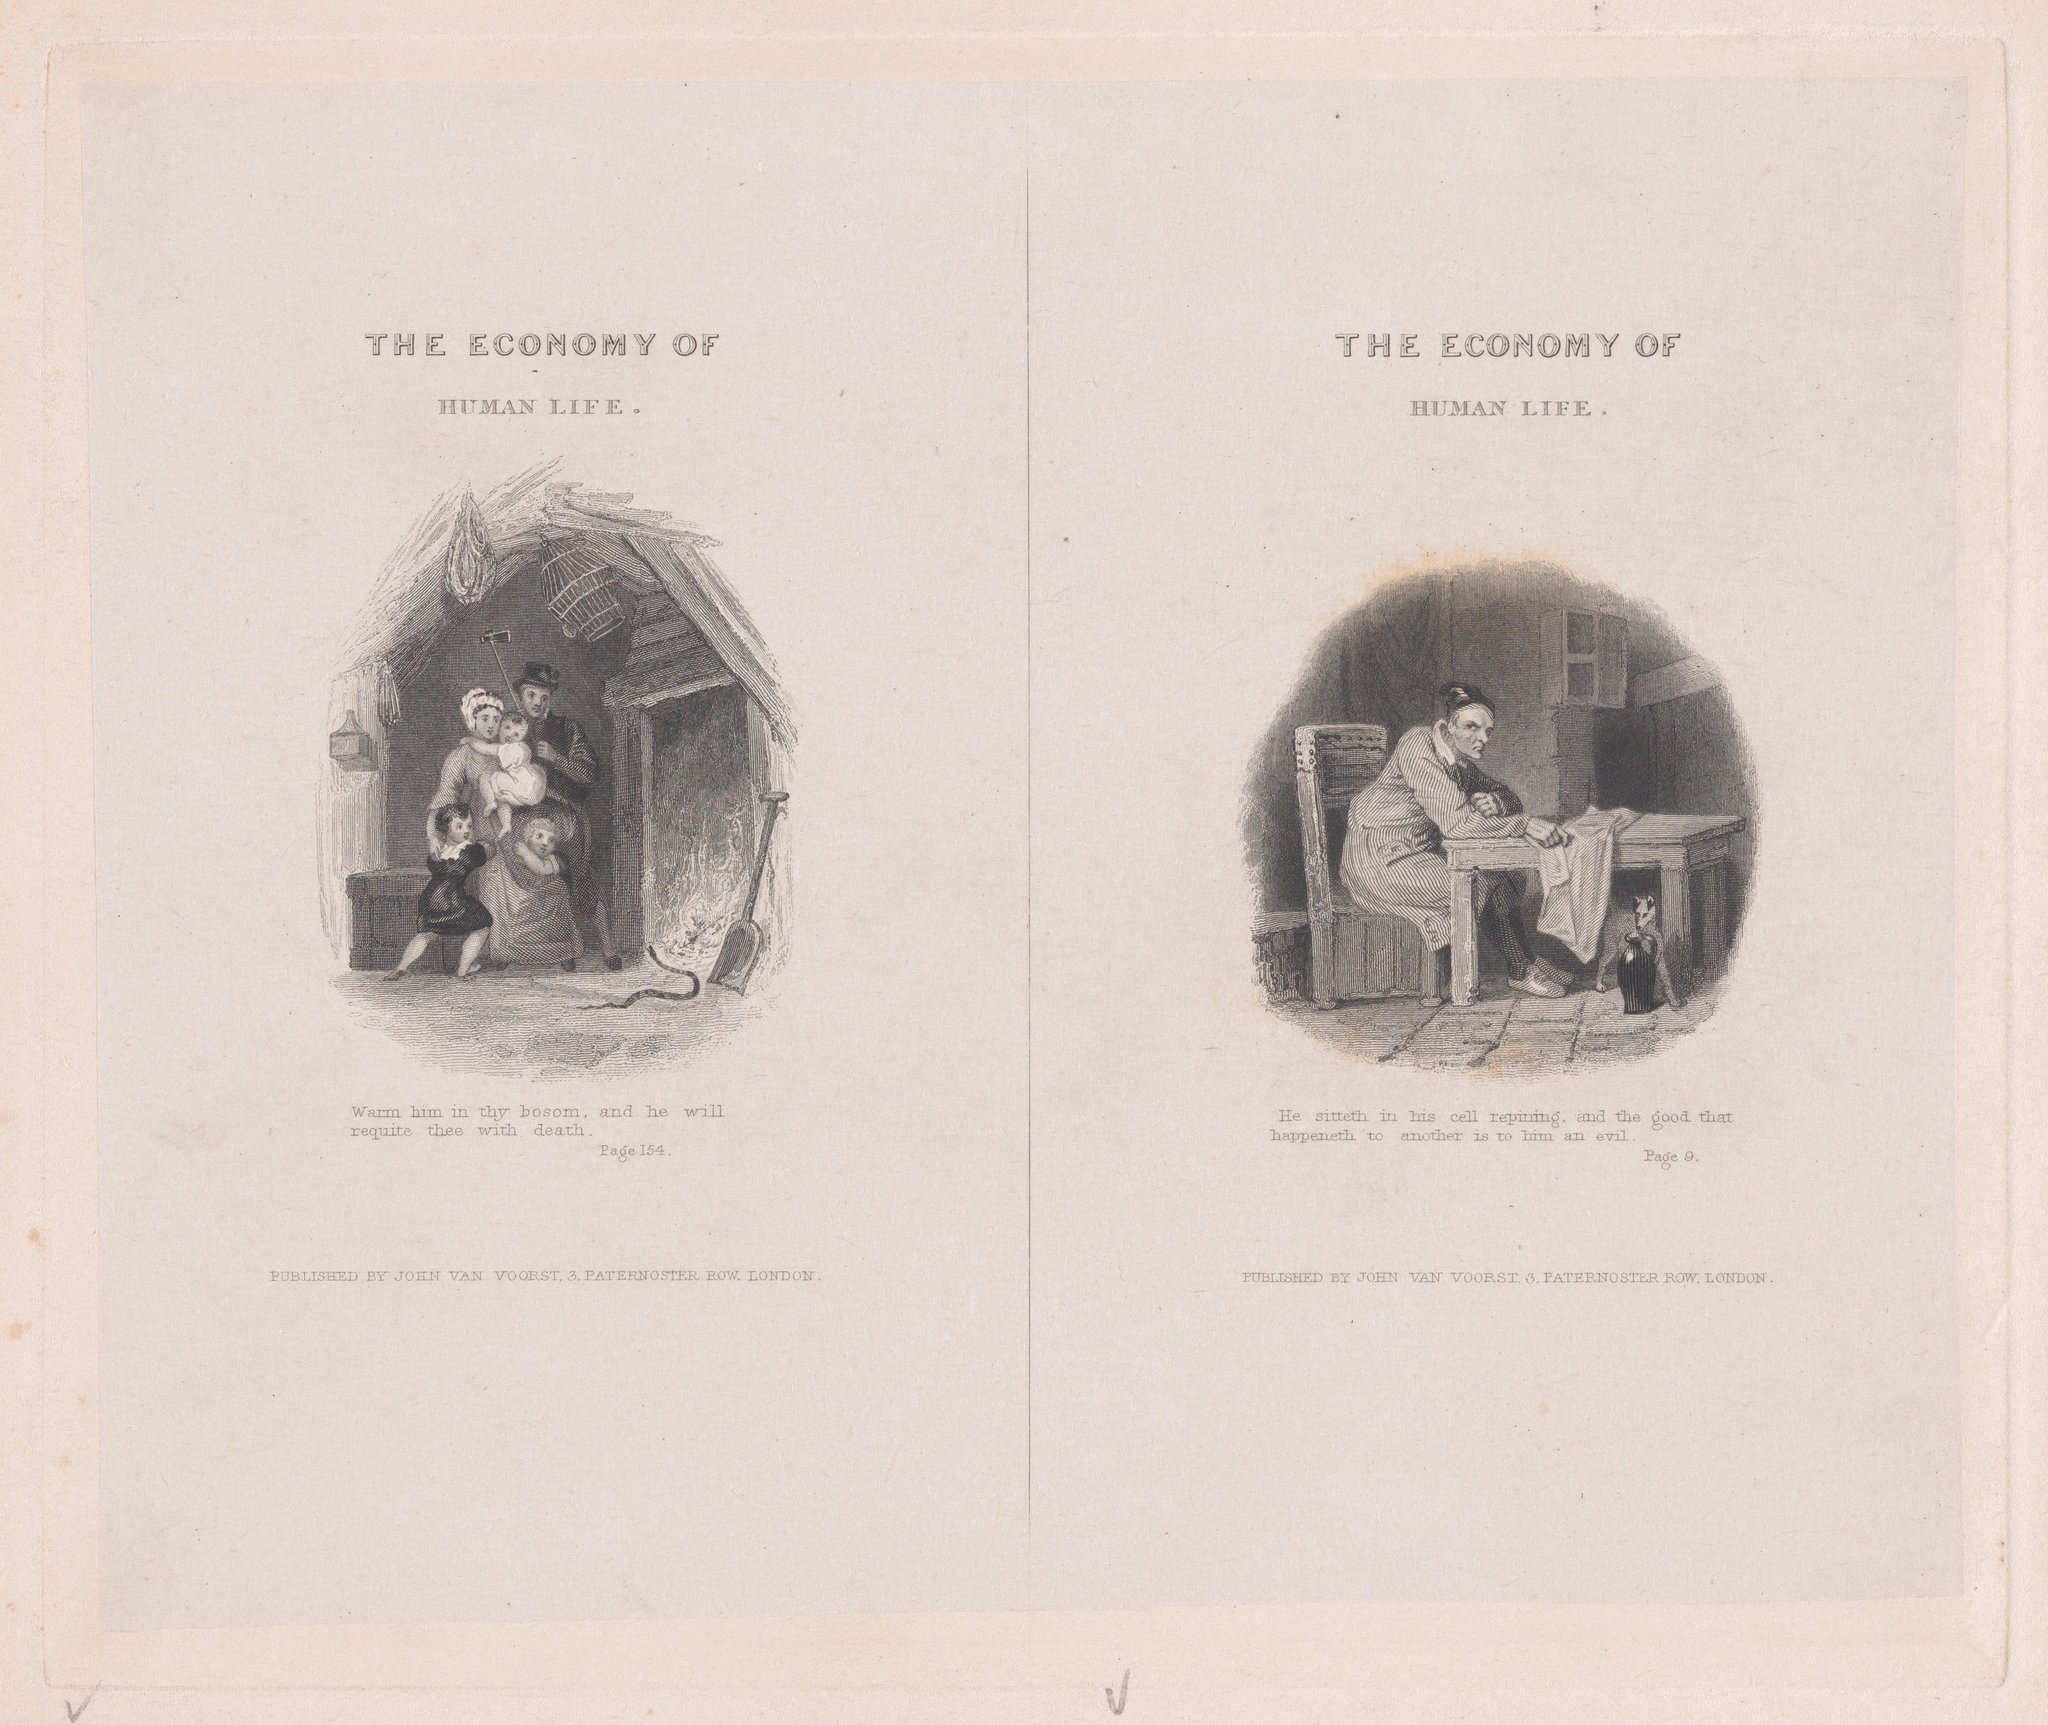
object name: print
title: Two illustrations for "The Economy of Human Life"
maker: frank howard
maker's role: artist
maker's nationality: british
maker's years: 1805-1866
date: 1834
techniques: printmaking, engraving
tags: fireplaces,children,men,women,snakes,tables